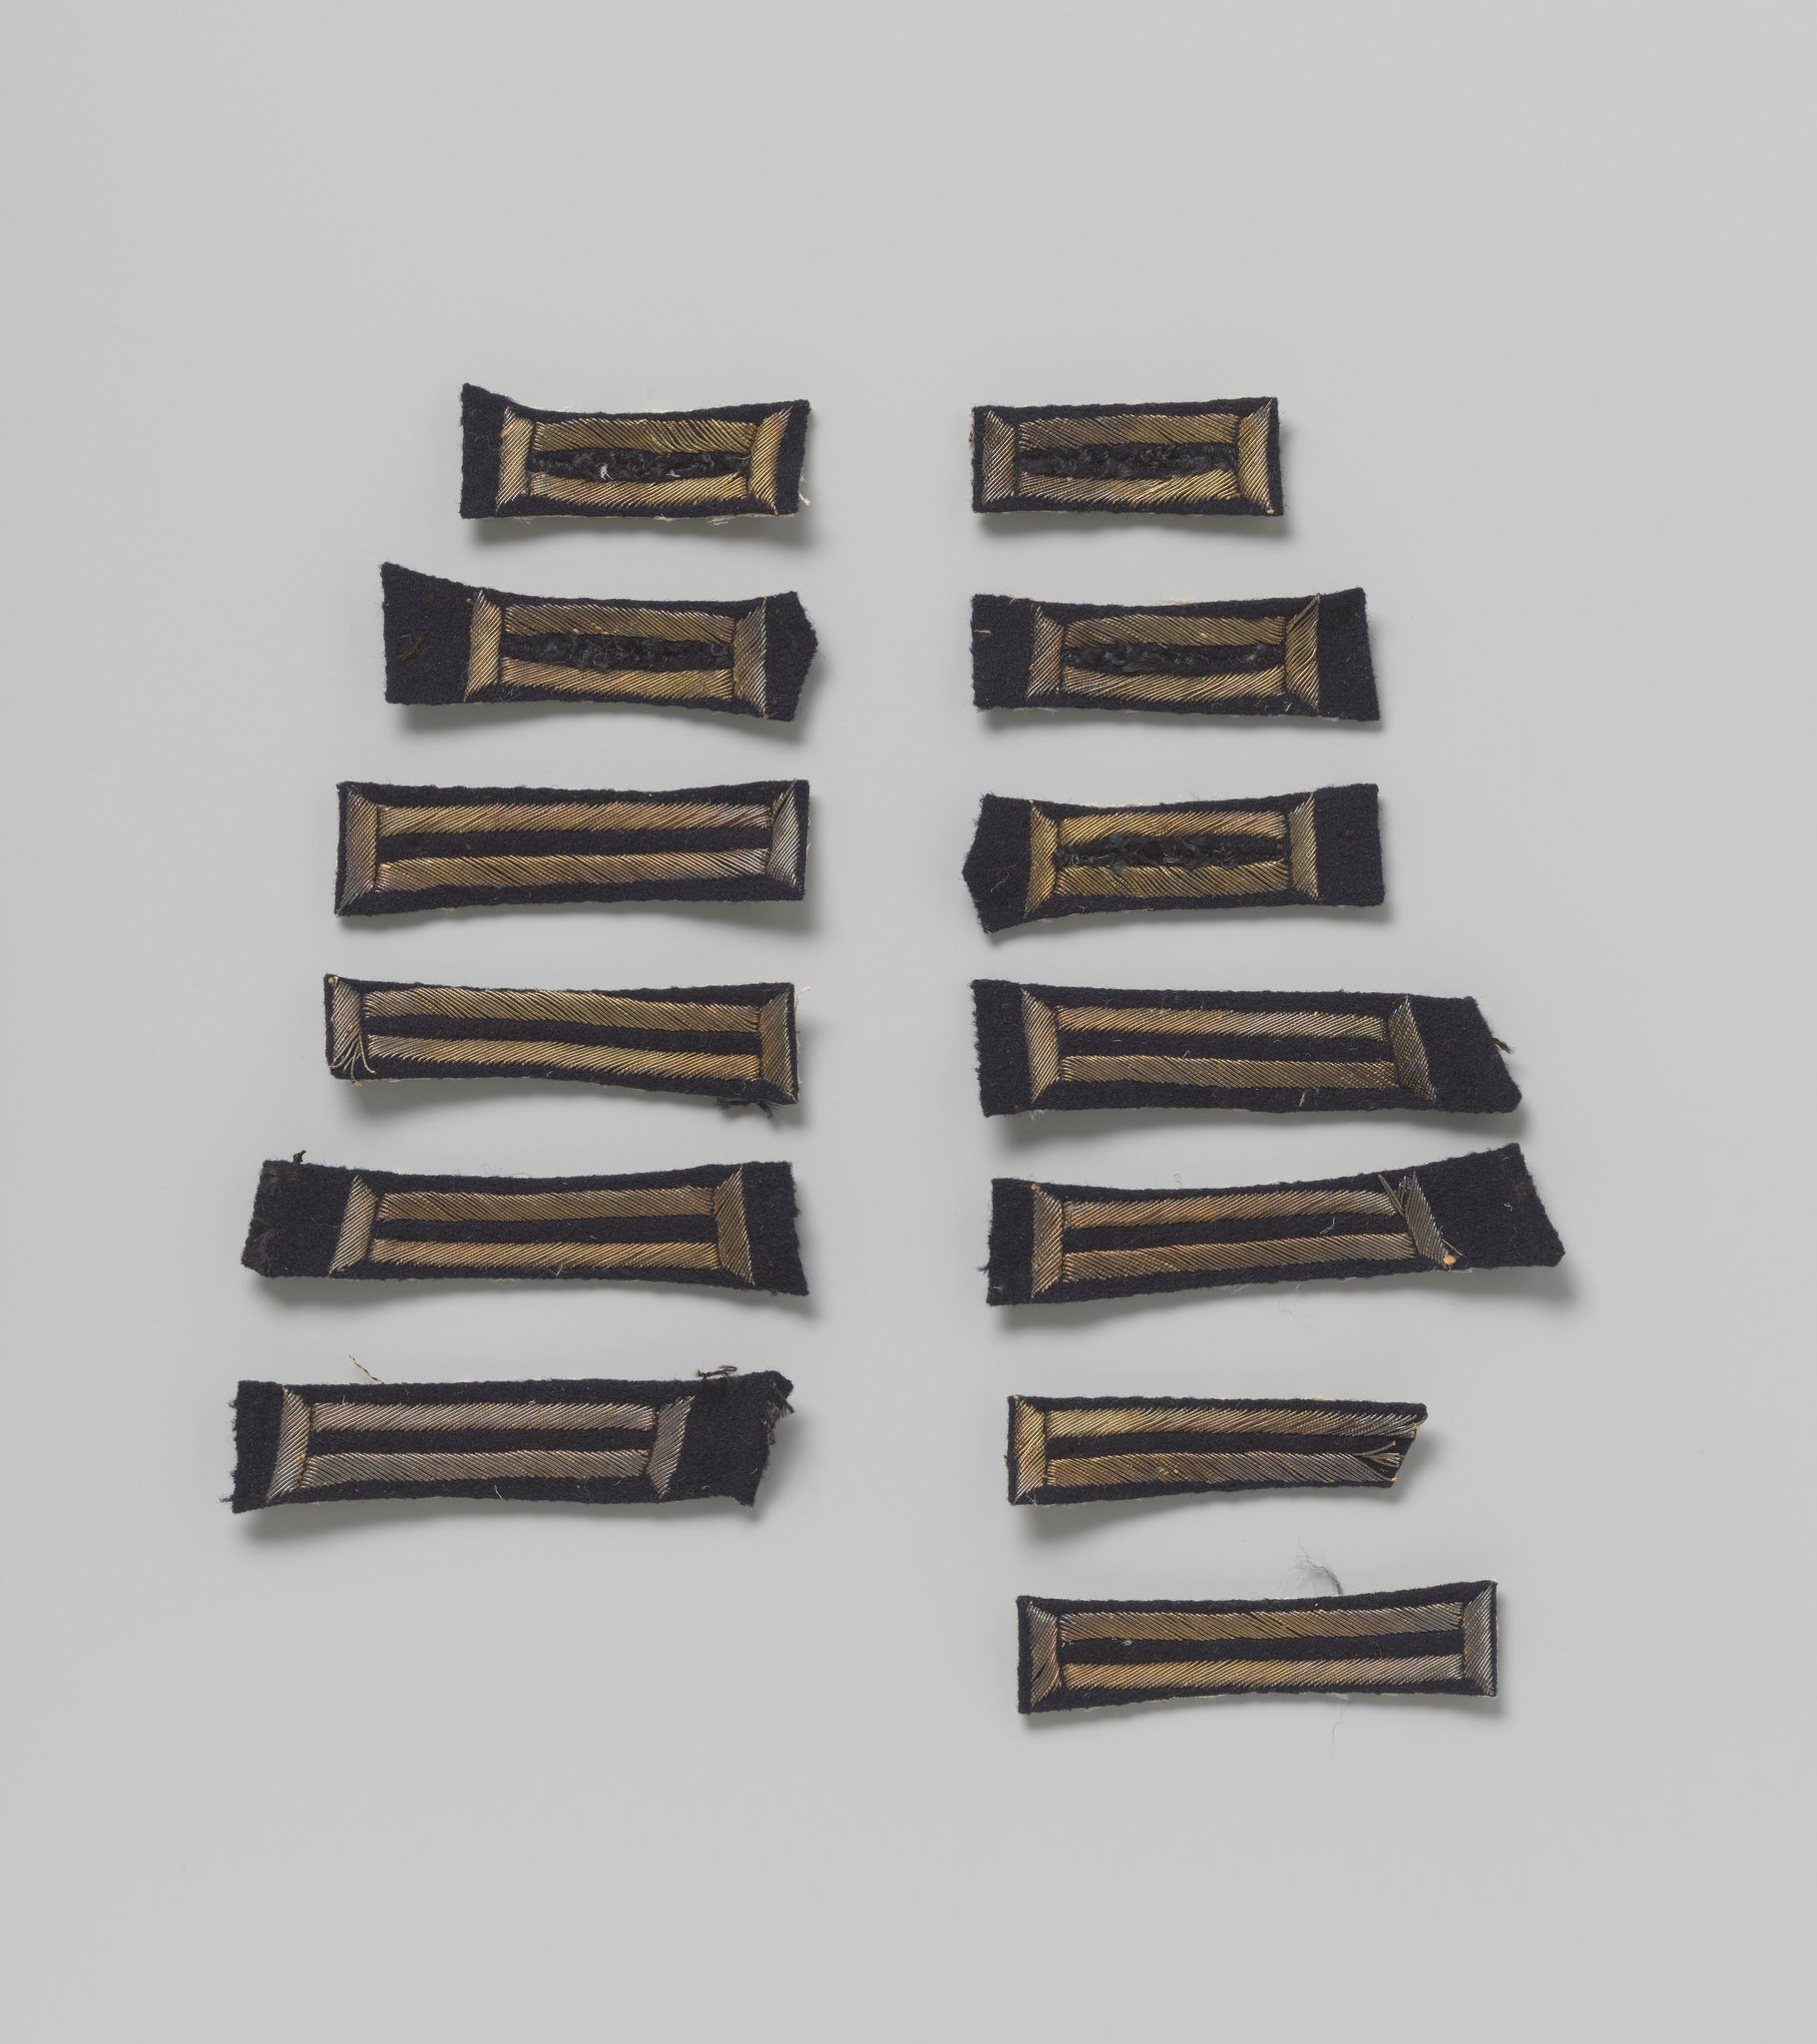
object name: kledingfragment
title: Lissen of knoopsgaten van donkerblauw laken, 13 stuks, waaromheen is geborduurd met zilverdraad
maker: Anonymous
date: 1800-1825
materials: textile, thread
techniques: embroidered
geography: netherlands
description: Lissen of knoopsgaten van donkerblauw laken, 13 stuks, waaromheen is geborduurd met zilverdraad. De lissen zijn verschillend van formaat. Uniformfragment voor livrei of schutterij (?)